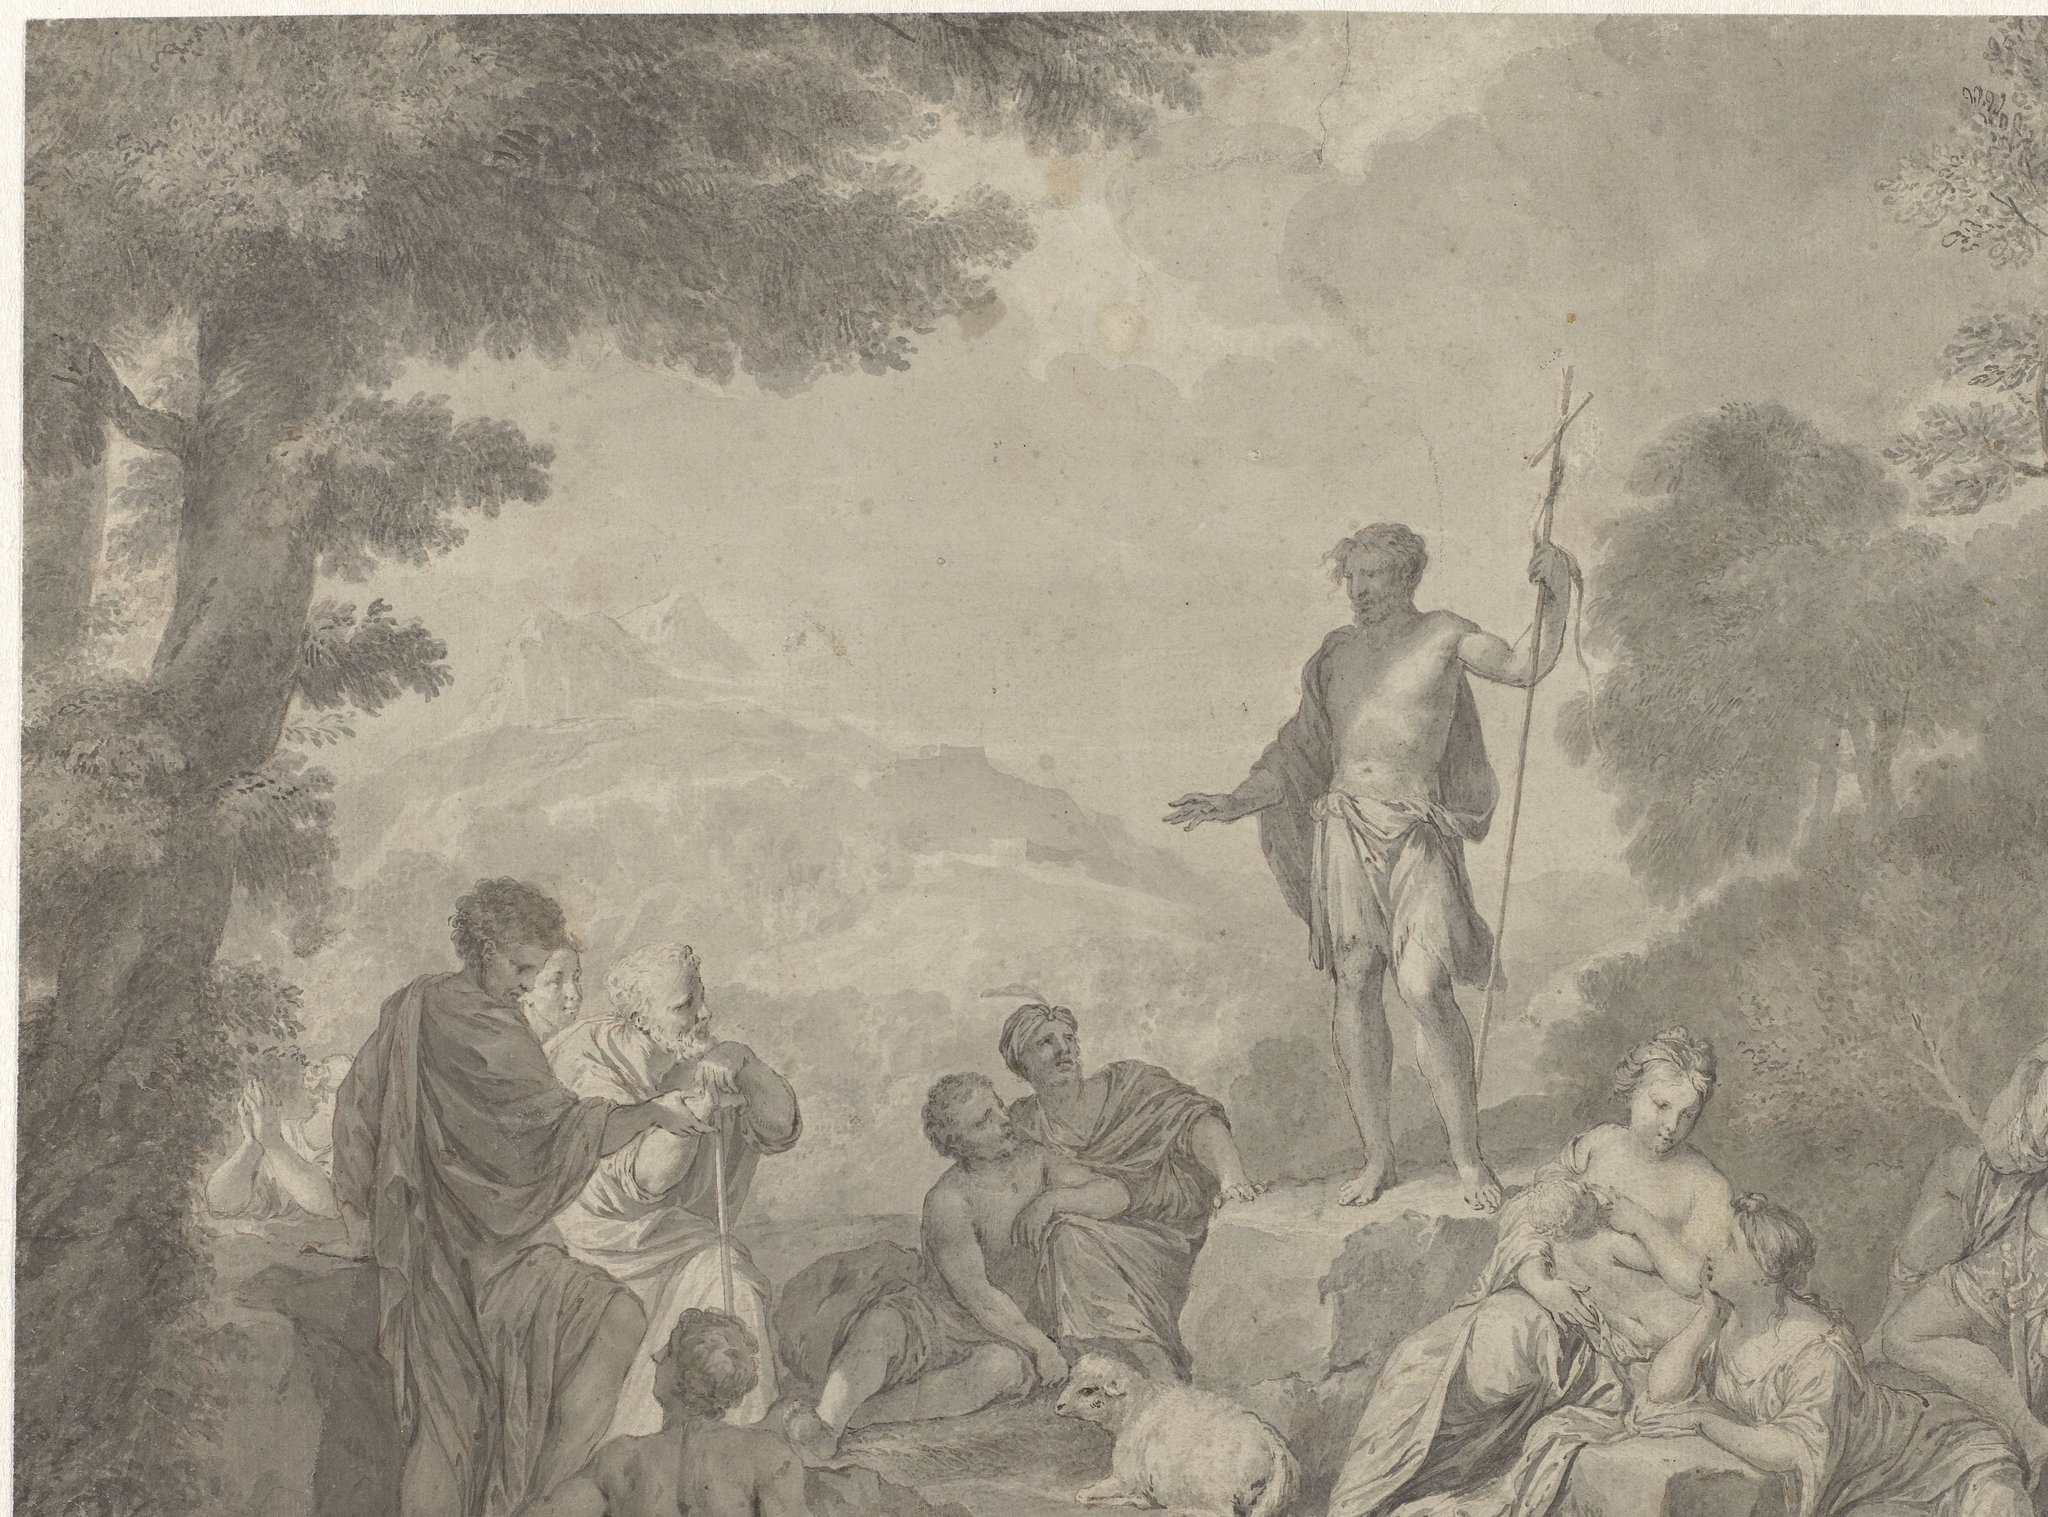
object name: drawing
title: Prediking van Johannes de Doper, in landschap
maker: nicolaas verkolje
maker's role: draughtsman, painter, print maker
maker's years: 1673-1746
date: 1683-1746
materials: ink, paper, pencil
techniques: brush, pen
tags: john the baptist preaching (perhaps christ among the bystanders)